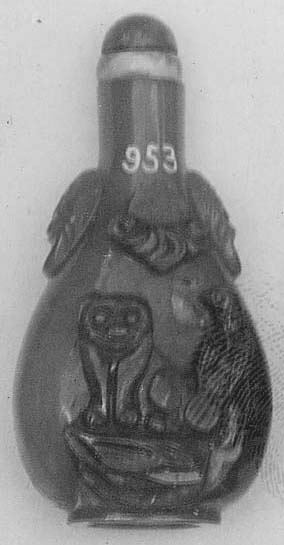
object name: snuff bottle with stopper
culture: chinese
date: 1701-1900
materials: stone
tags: animals